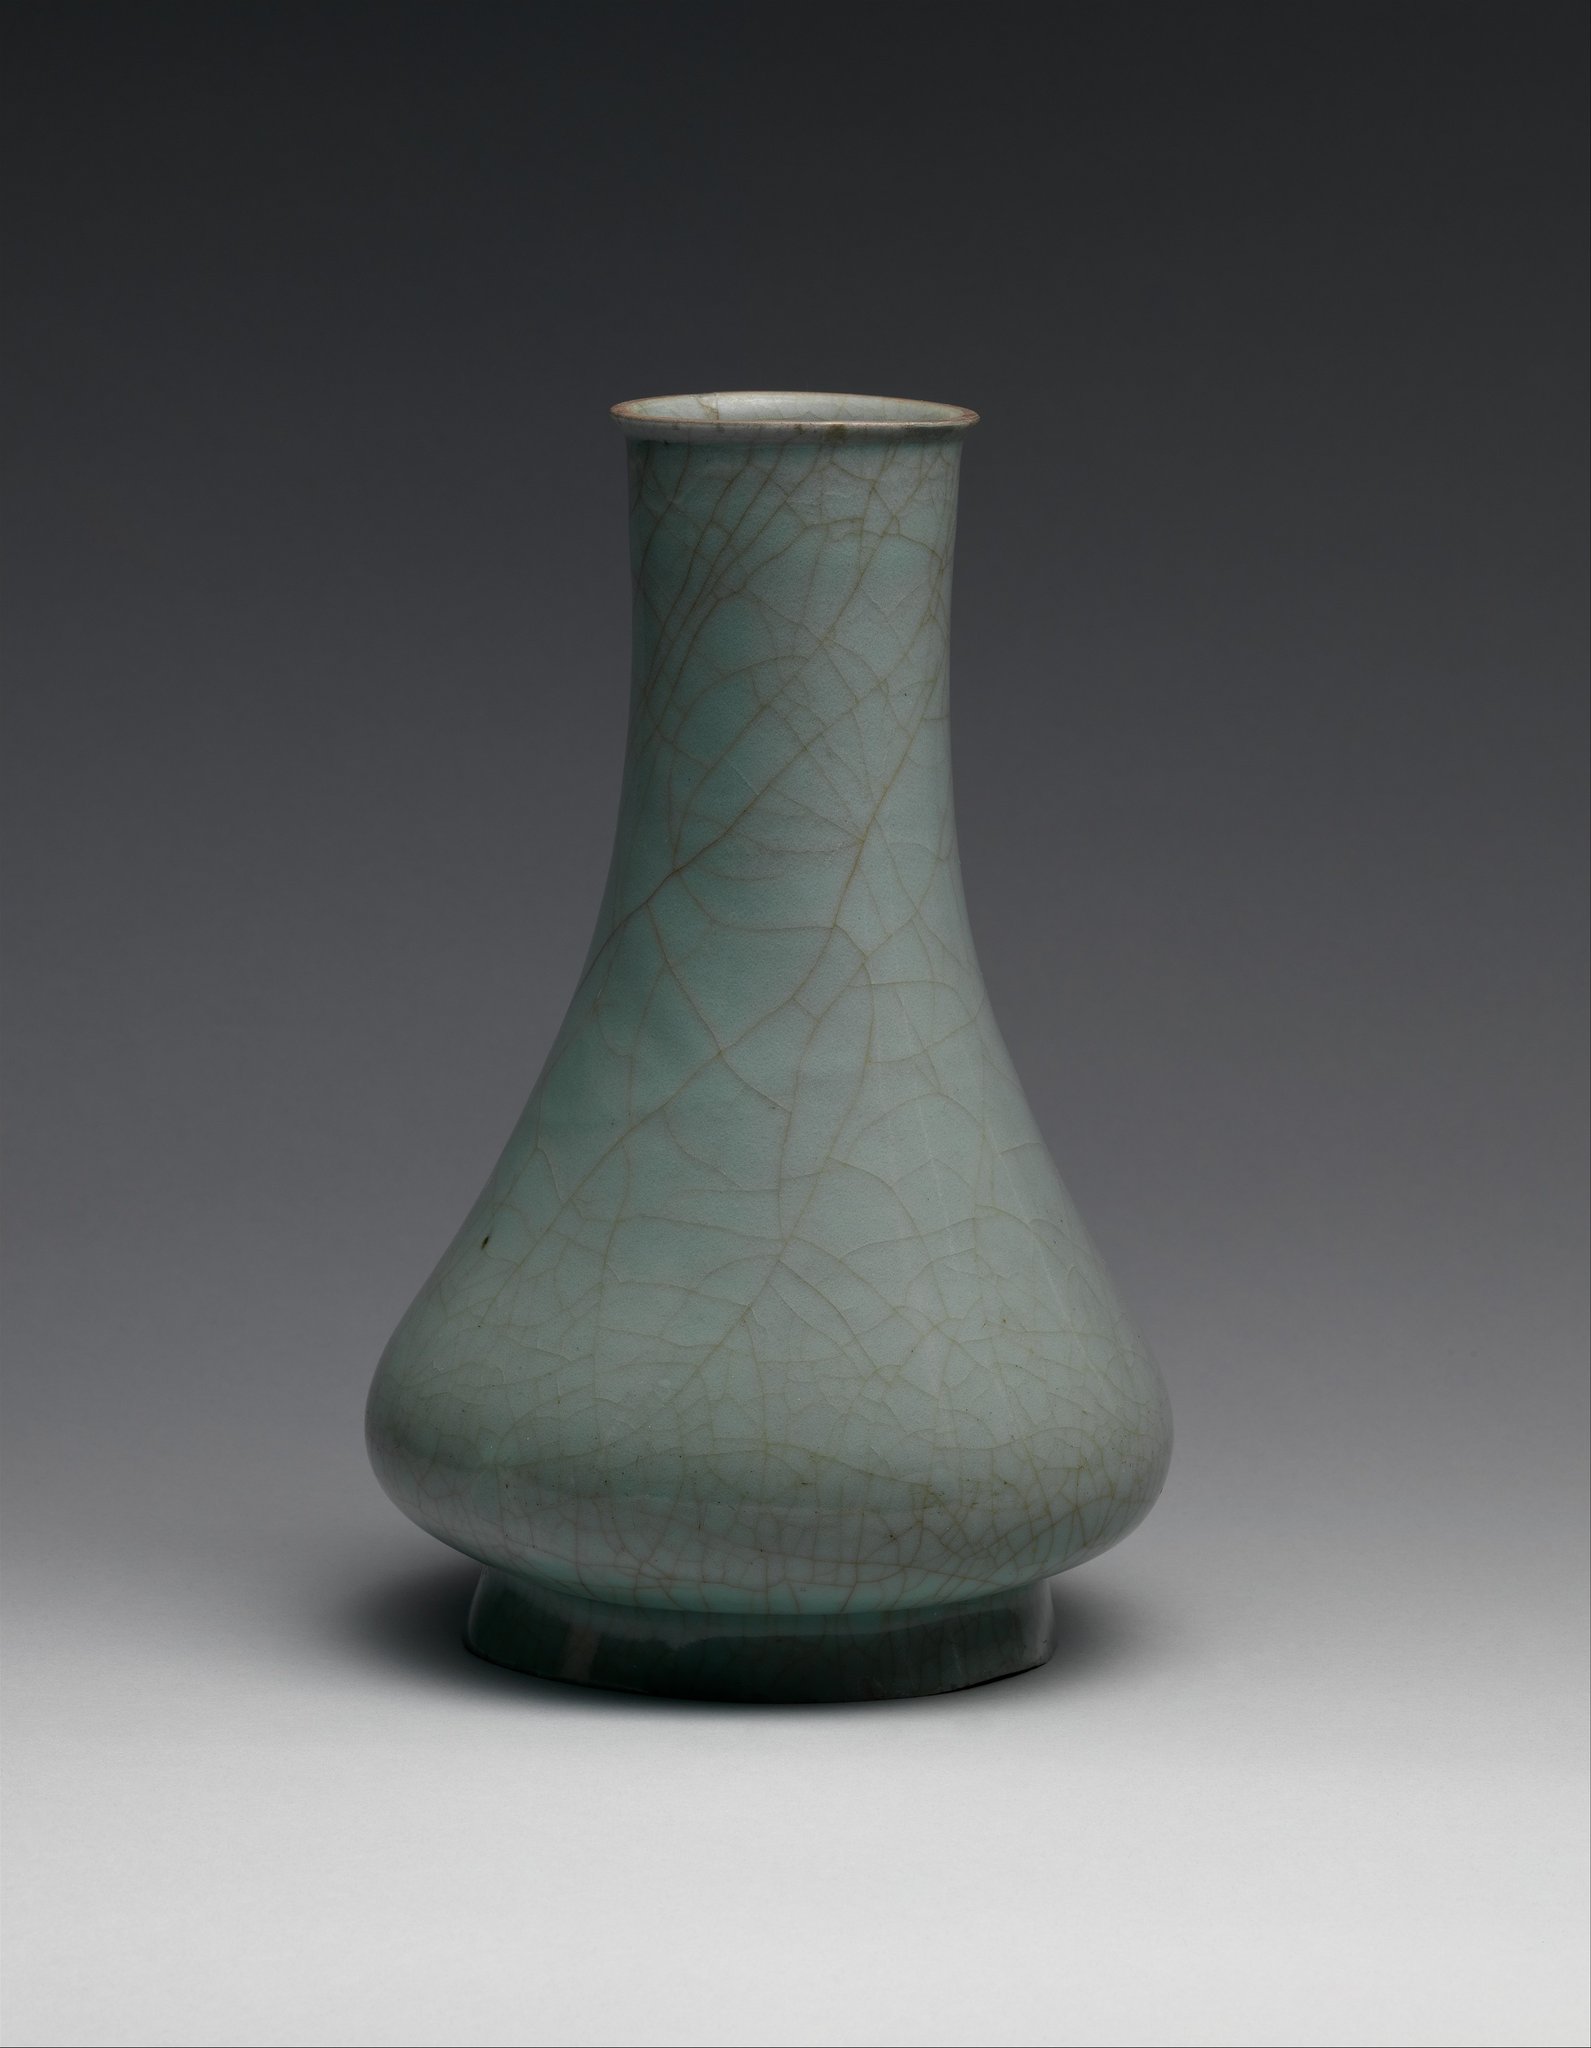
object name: vase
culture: chinese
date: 1127-1279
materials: glaze, stoneware